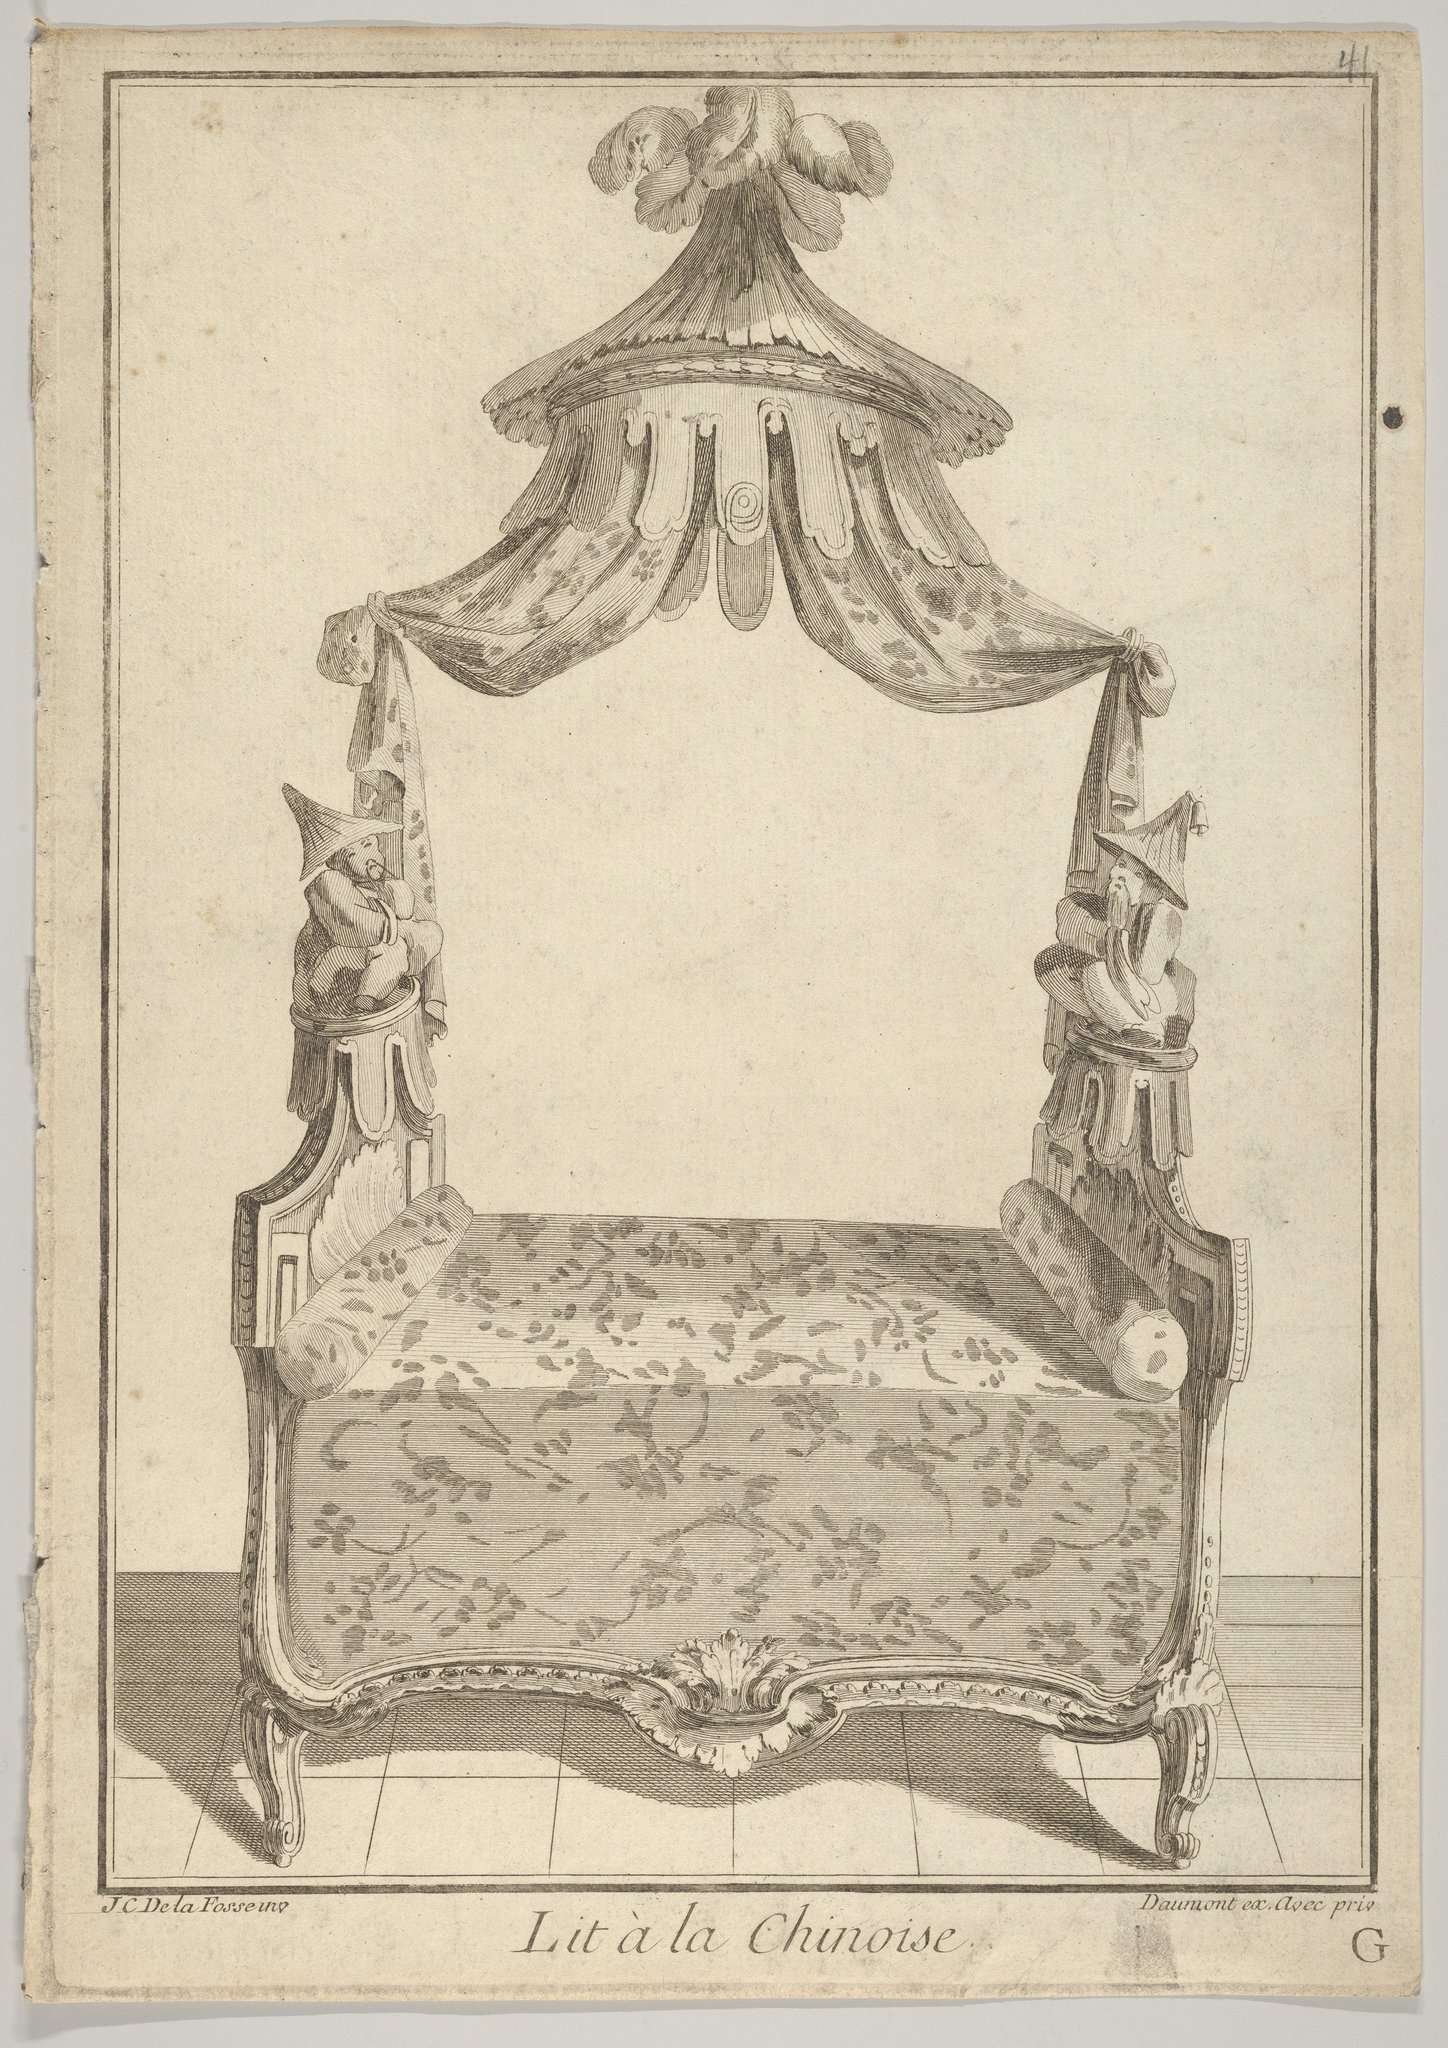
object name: print ornament architecture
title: Lit à la Chinoise (Chinese Bed), from Nouvelle iconologie historique (part III, series marked 'G')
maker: jean charles delafosse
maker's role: artist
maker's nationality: french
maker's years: 1734-1789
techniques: engraving, etching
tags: beds